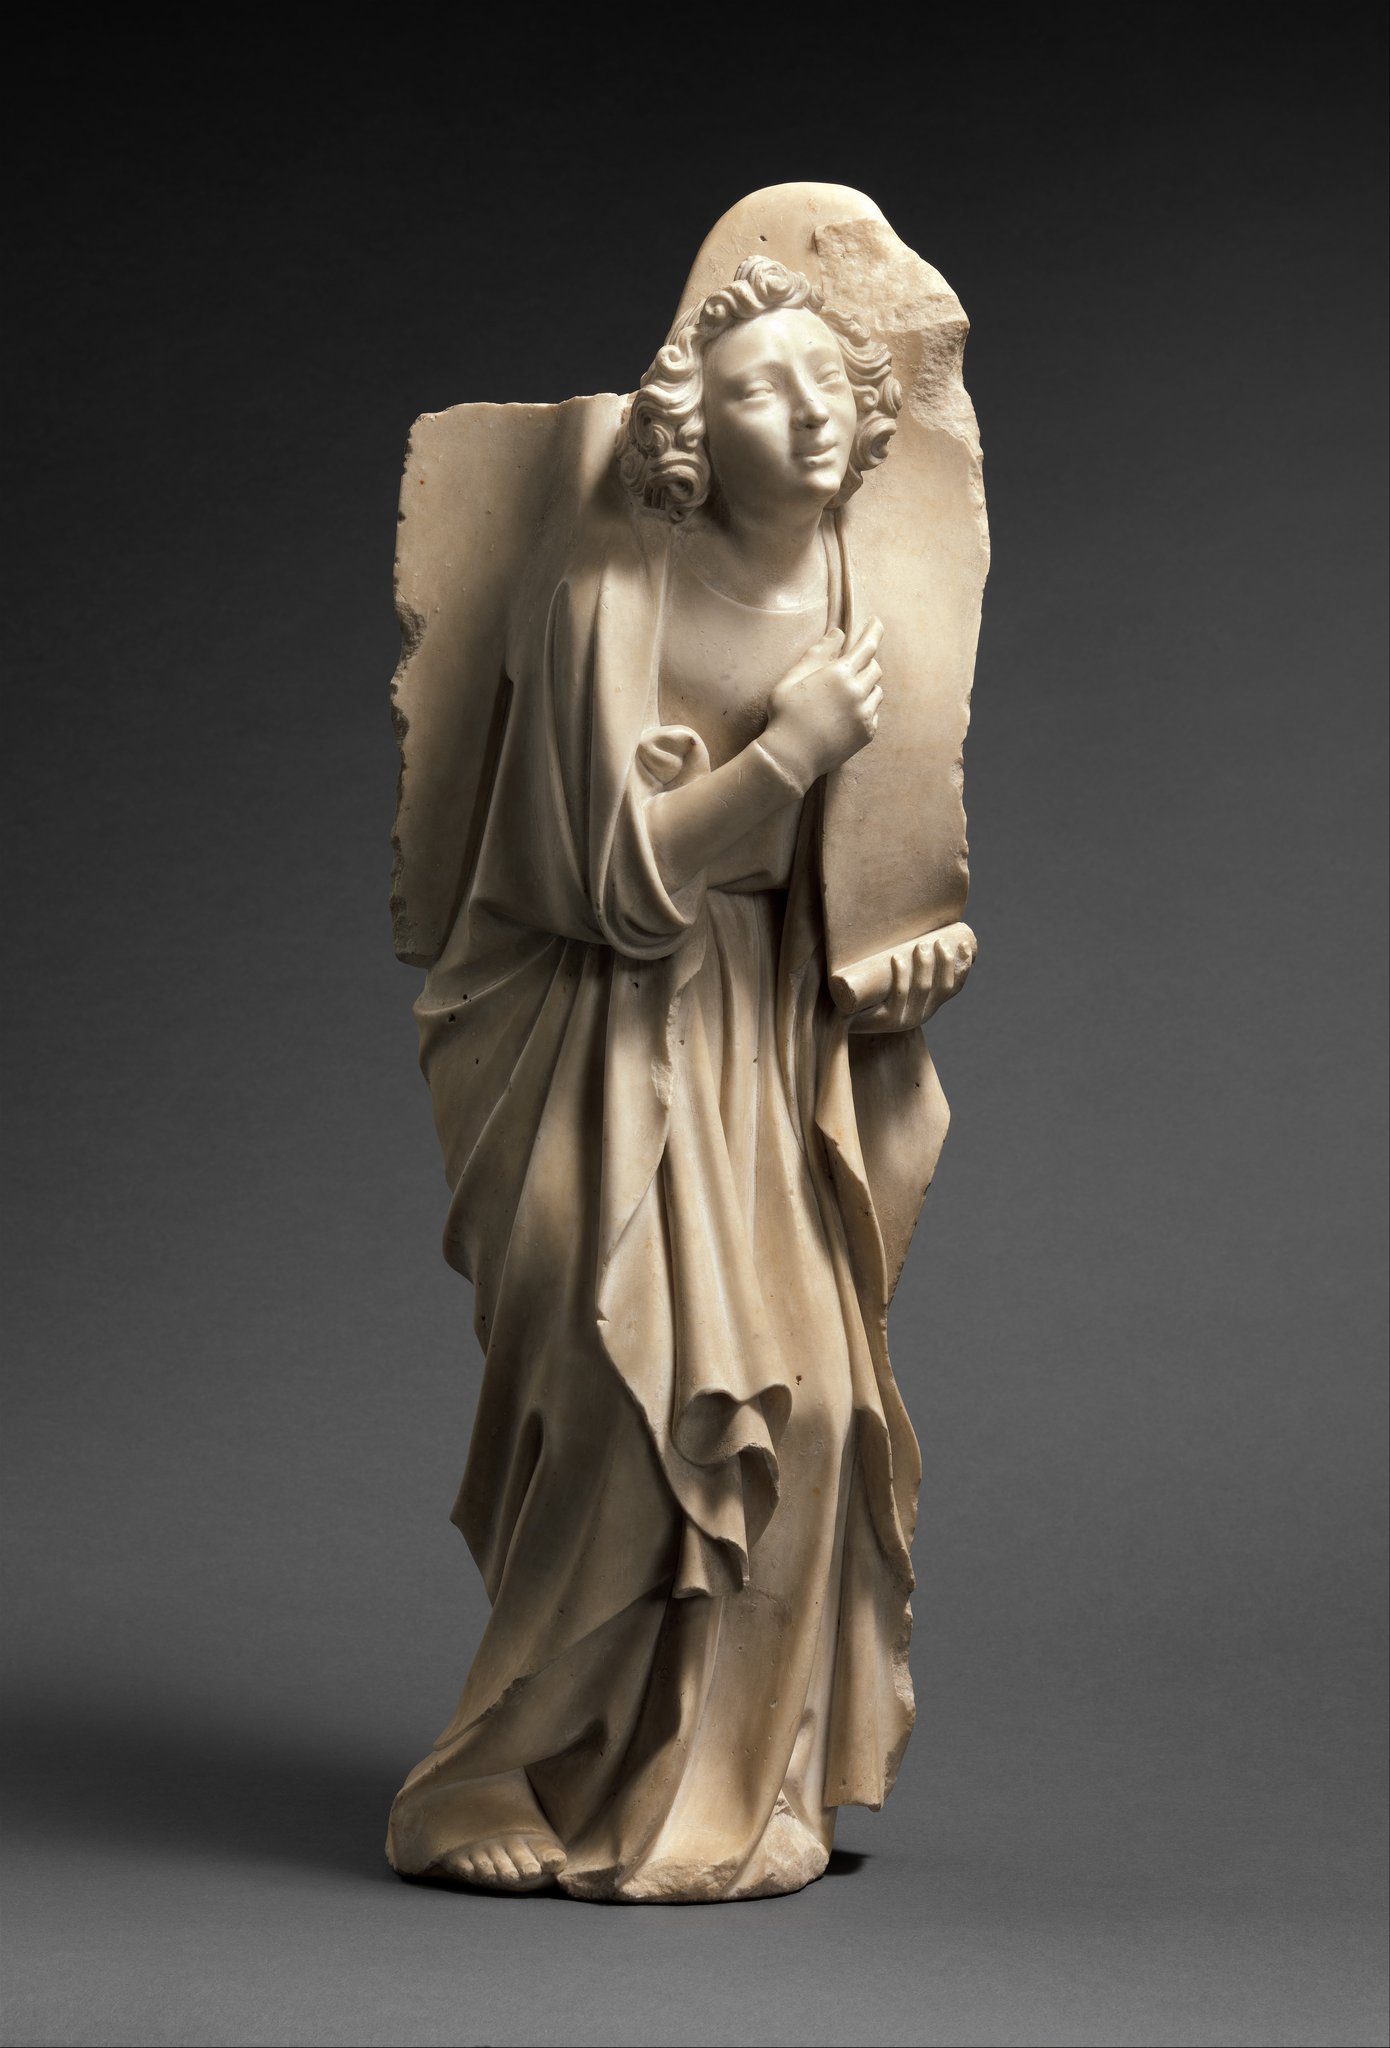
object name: statuette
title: Angel of the Annunciation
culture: french or south netherlandish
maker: jean de liège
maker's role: artist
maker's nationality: franco-netherlandish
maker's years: 1361-1381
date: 1370-1390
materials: marble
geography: netherlands or france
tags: angels